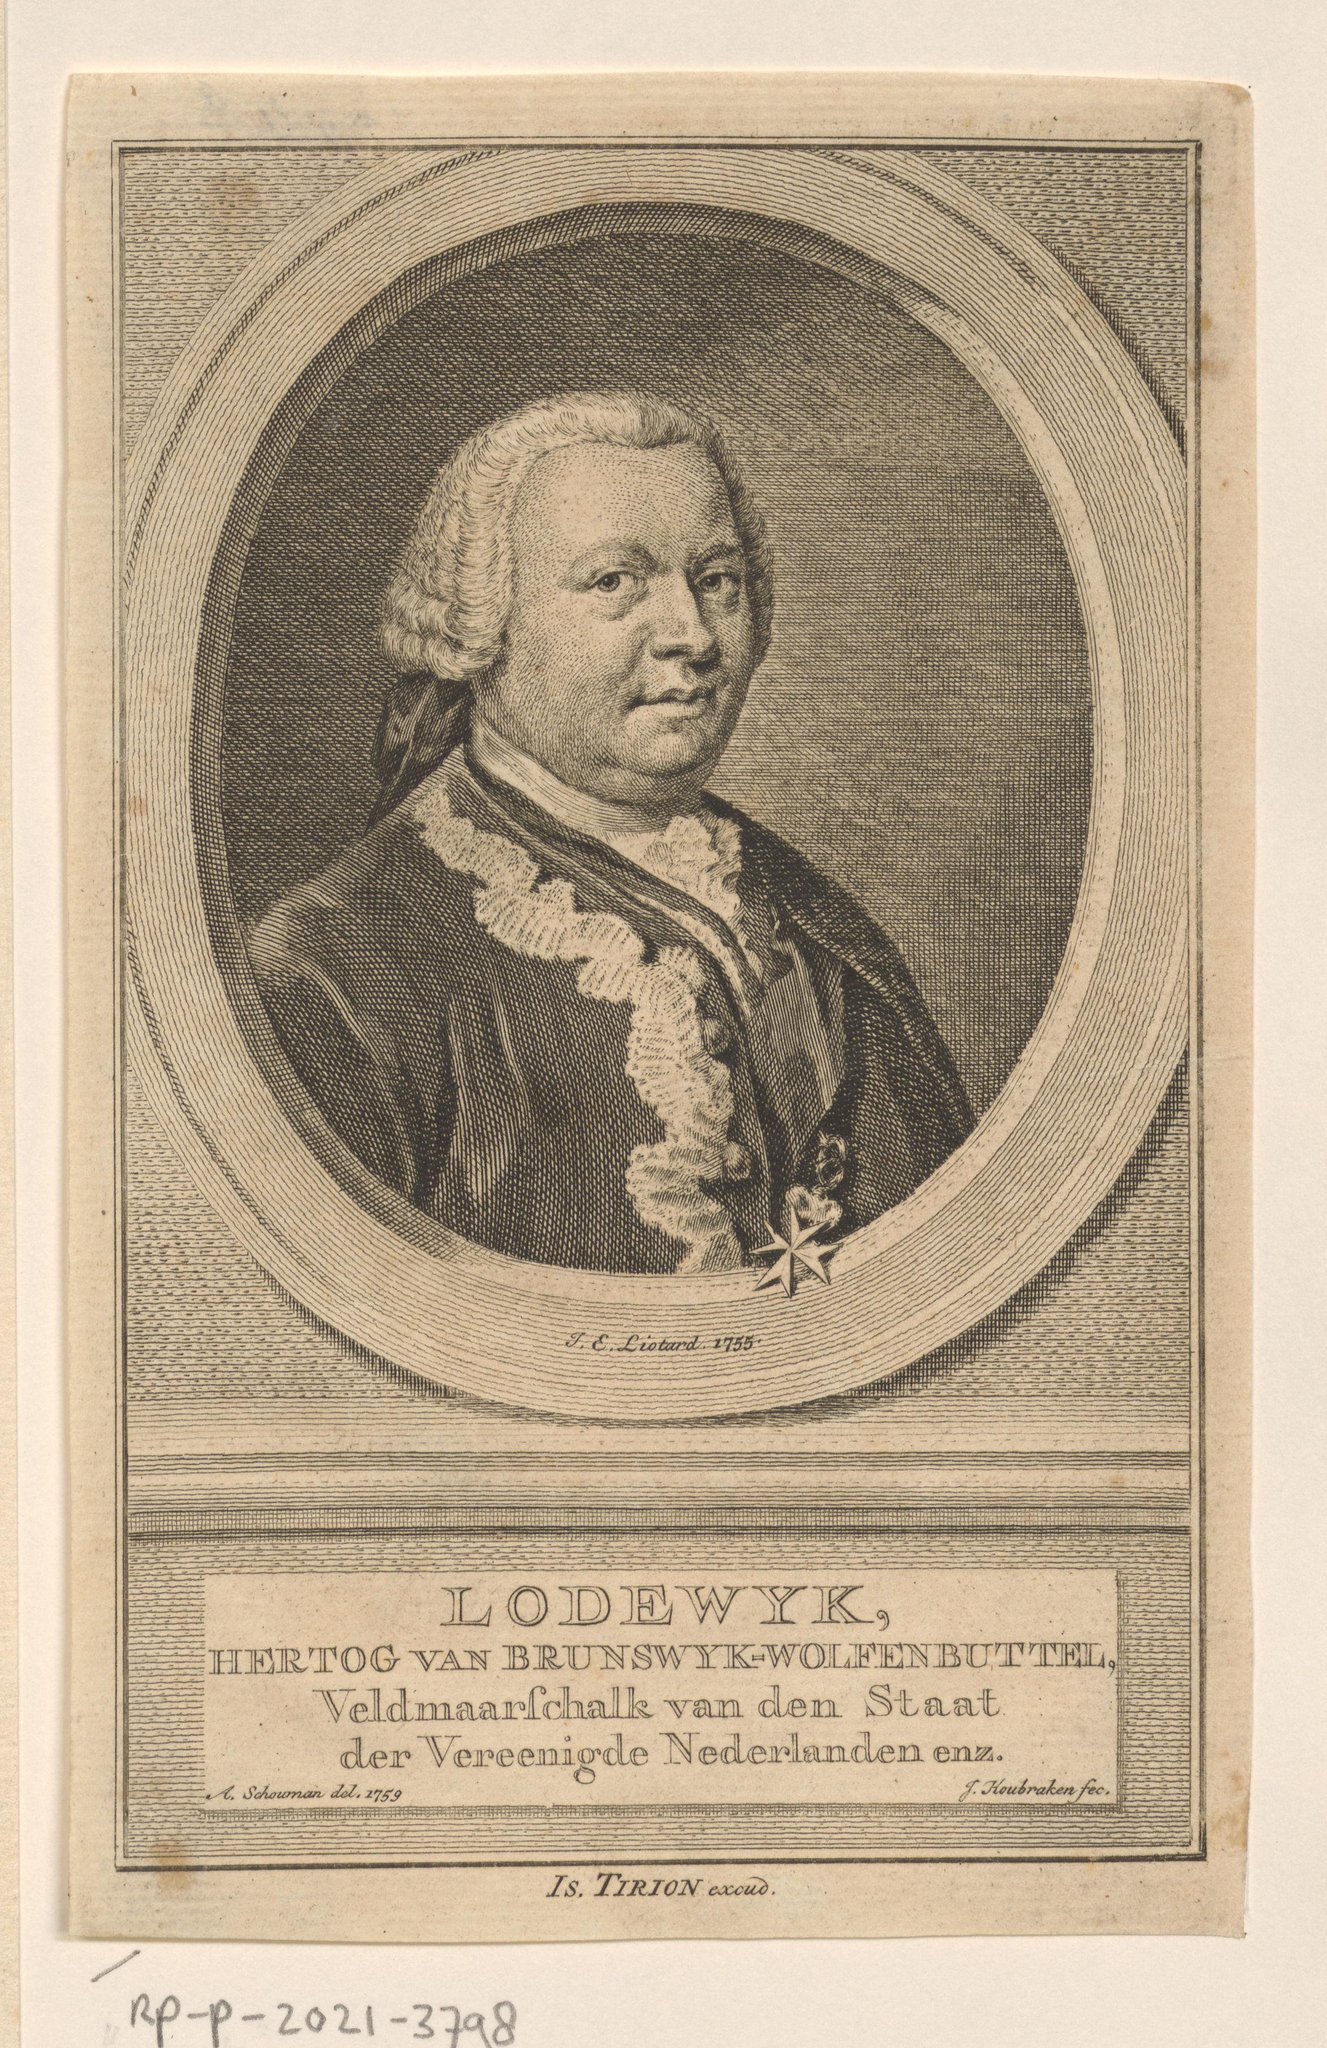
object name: print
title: Portret van Lodewijk Ernst, hertog van Brunswijk-Wolfenbüttel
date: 1796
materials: paper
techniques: engraving, etching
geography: amsterdam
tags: ludwig ernst von braunschweig-wolfenbüttel, ornament ~ medallion, historical persons, wig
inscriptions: collector's mark: Lugt 2228, number: ‘1504a’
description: Prent waarschijnlijk uit: Wagenaar, Jan. Vaderlandsche historie, vervattende de geschiedenissen der nu Vereenigde Nederlanden, inzonderheid die van Holland (...). Amsterdam: Johannes Allart, 1796, dl. 20. Prent is in eerdere staten gebruikt in eerdere drukken van dit werk uit 1759, 1770 en 1782.